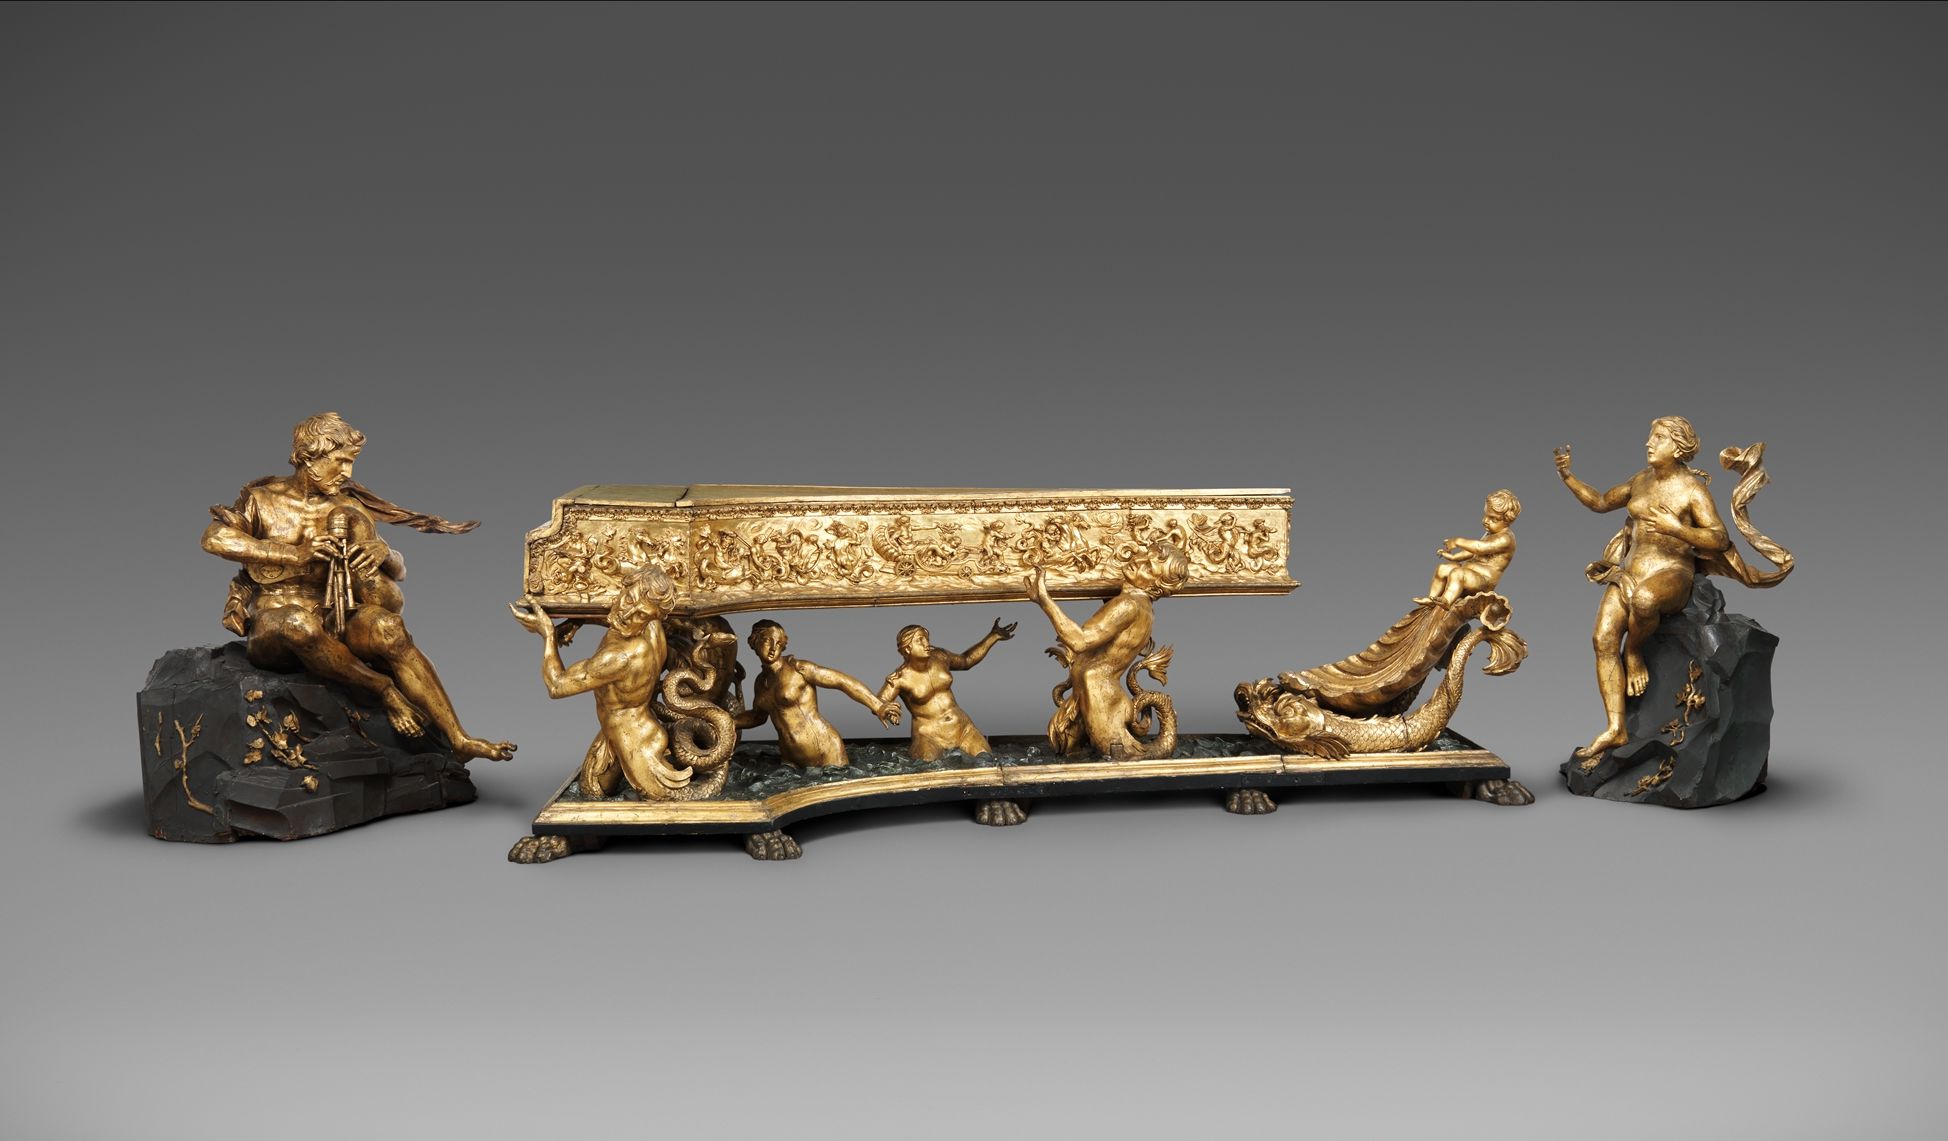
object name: harpsichord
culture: italian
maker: michele todini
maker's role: designer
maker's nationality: italian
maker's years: 1616-1690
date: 1670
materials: wood, gilt, ivory, parchment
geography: italy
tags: triton,galatea,nymphs,fish